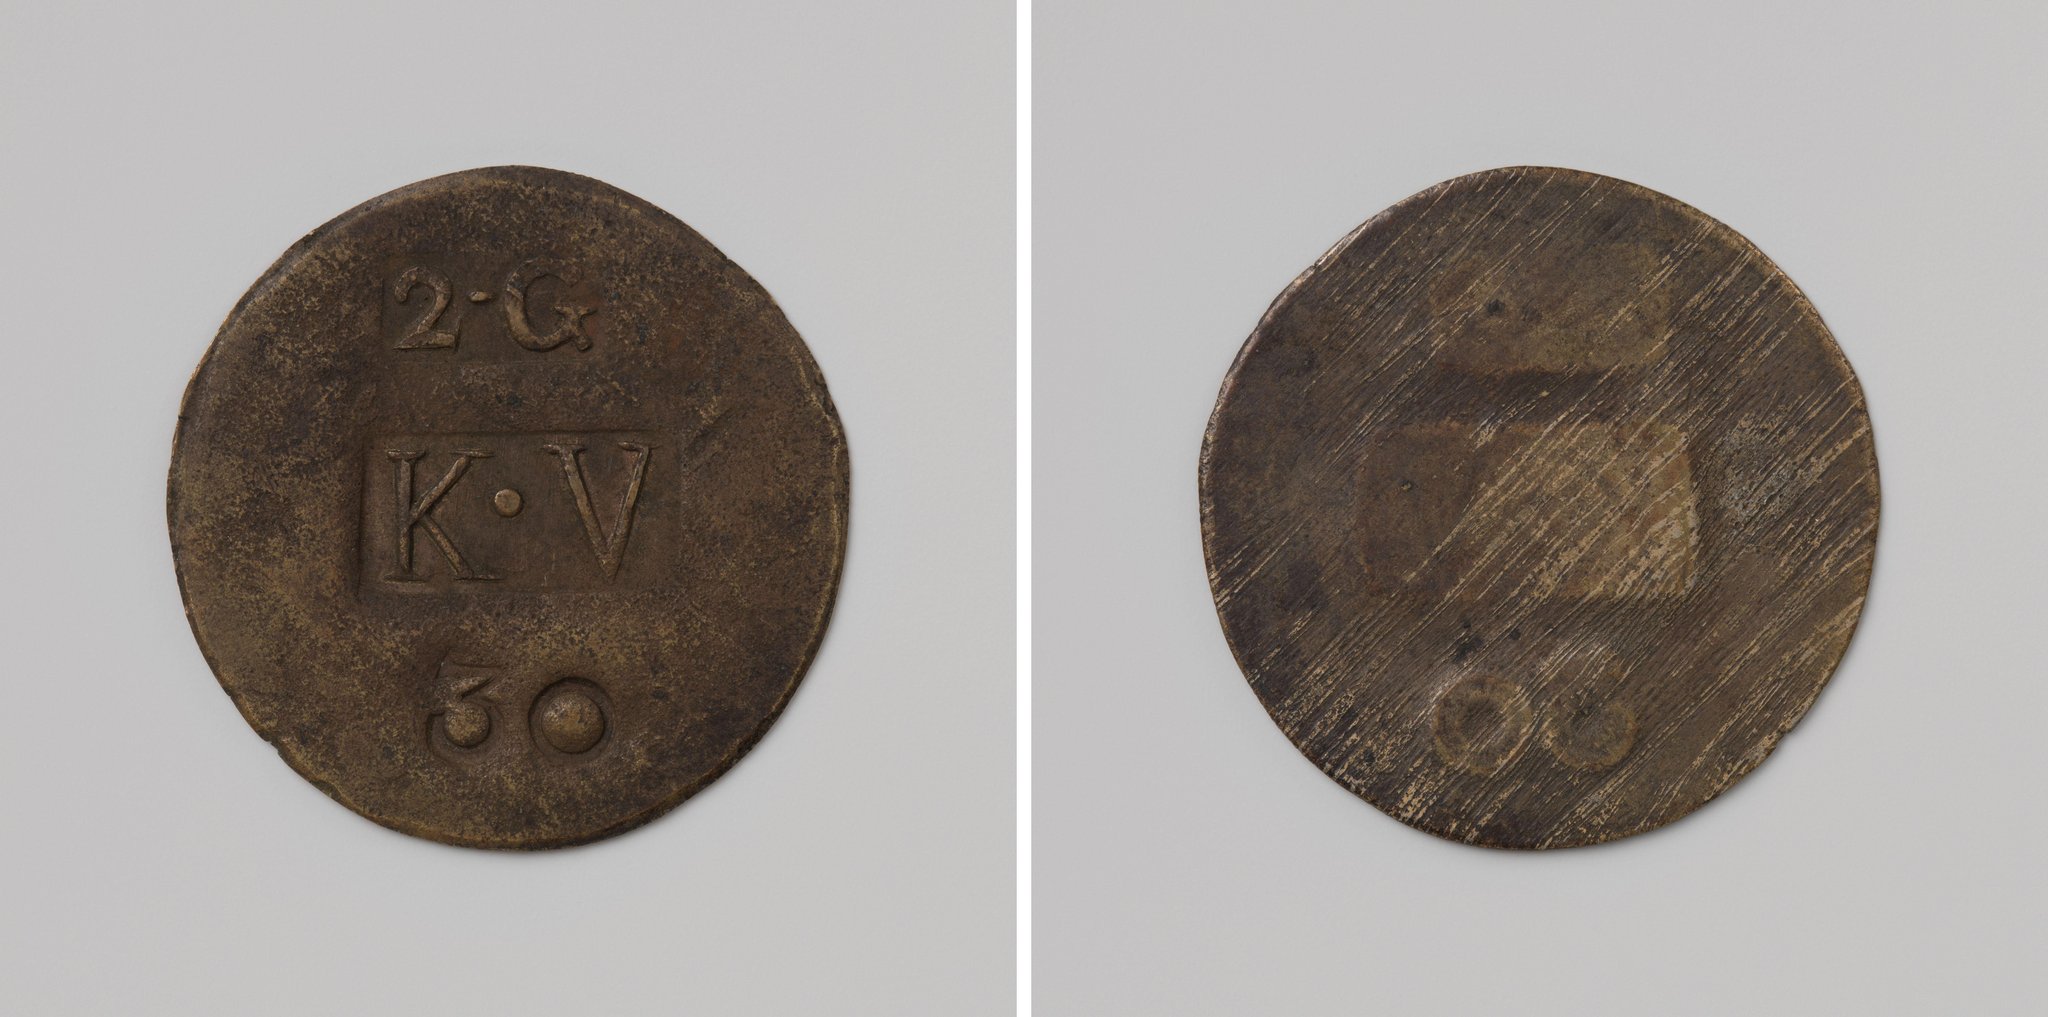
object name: monetary token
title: Huismunt ter waarde van dertig cent, geslagen op last van de Maatschappij van Weldadigheid ten behoeve van het Tweede gesticht van de kolonie Veenhuizen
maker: Anonymous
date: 1818-1859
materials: brass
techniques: striking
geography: netherlands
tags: maatschappij van weldadigheid, veenhuizen